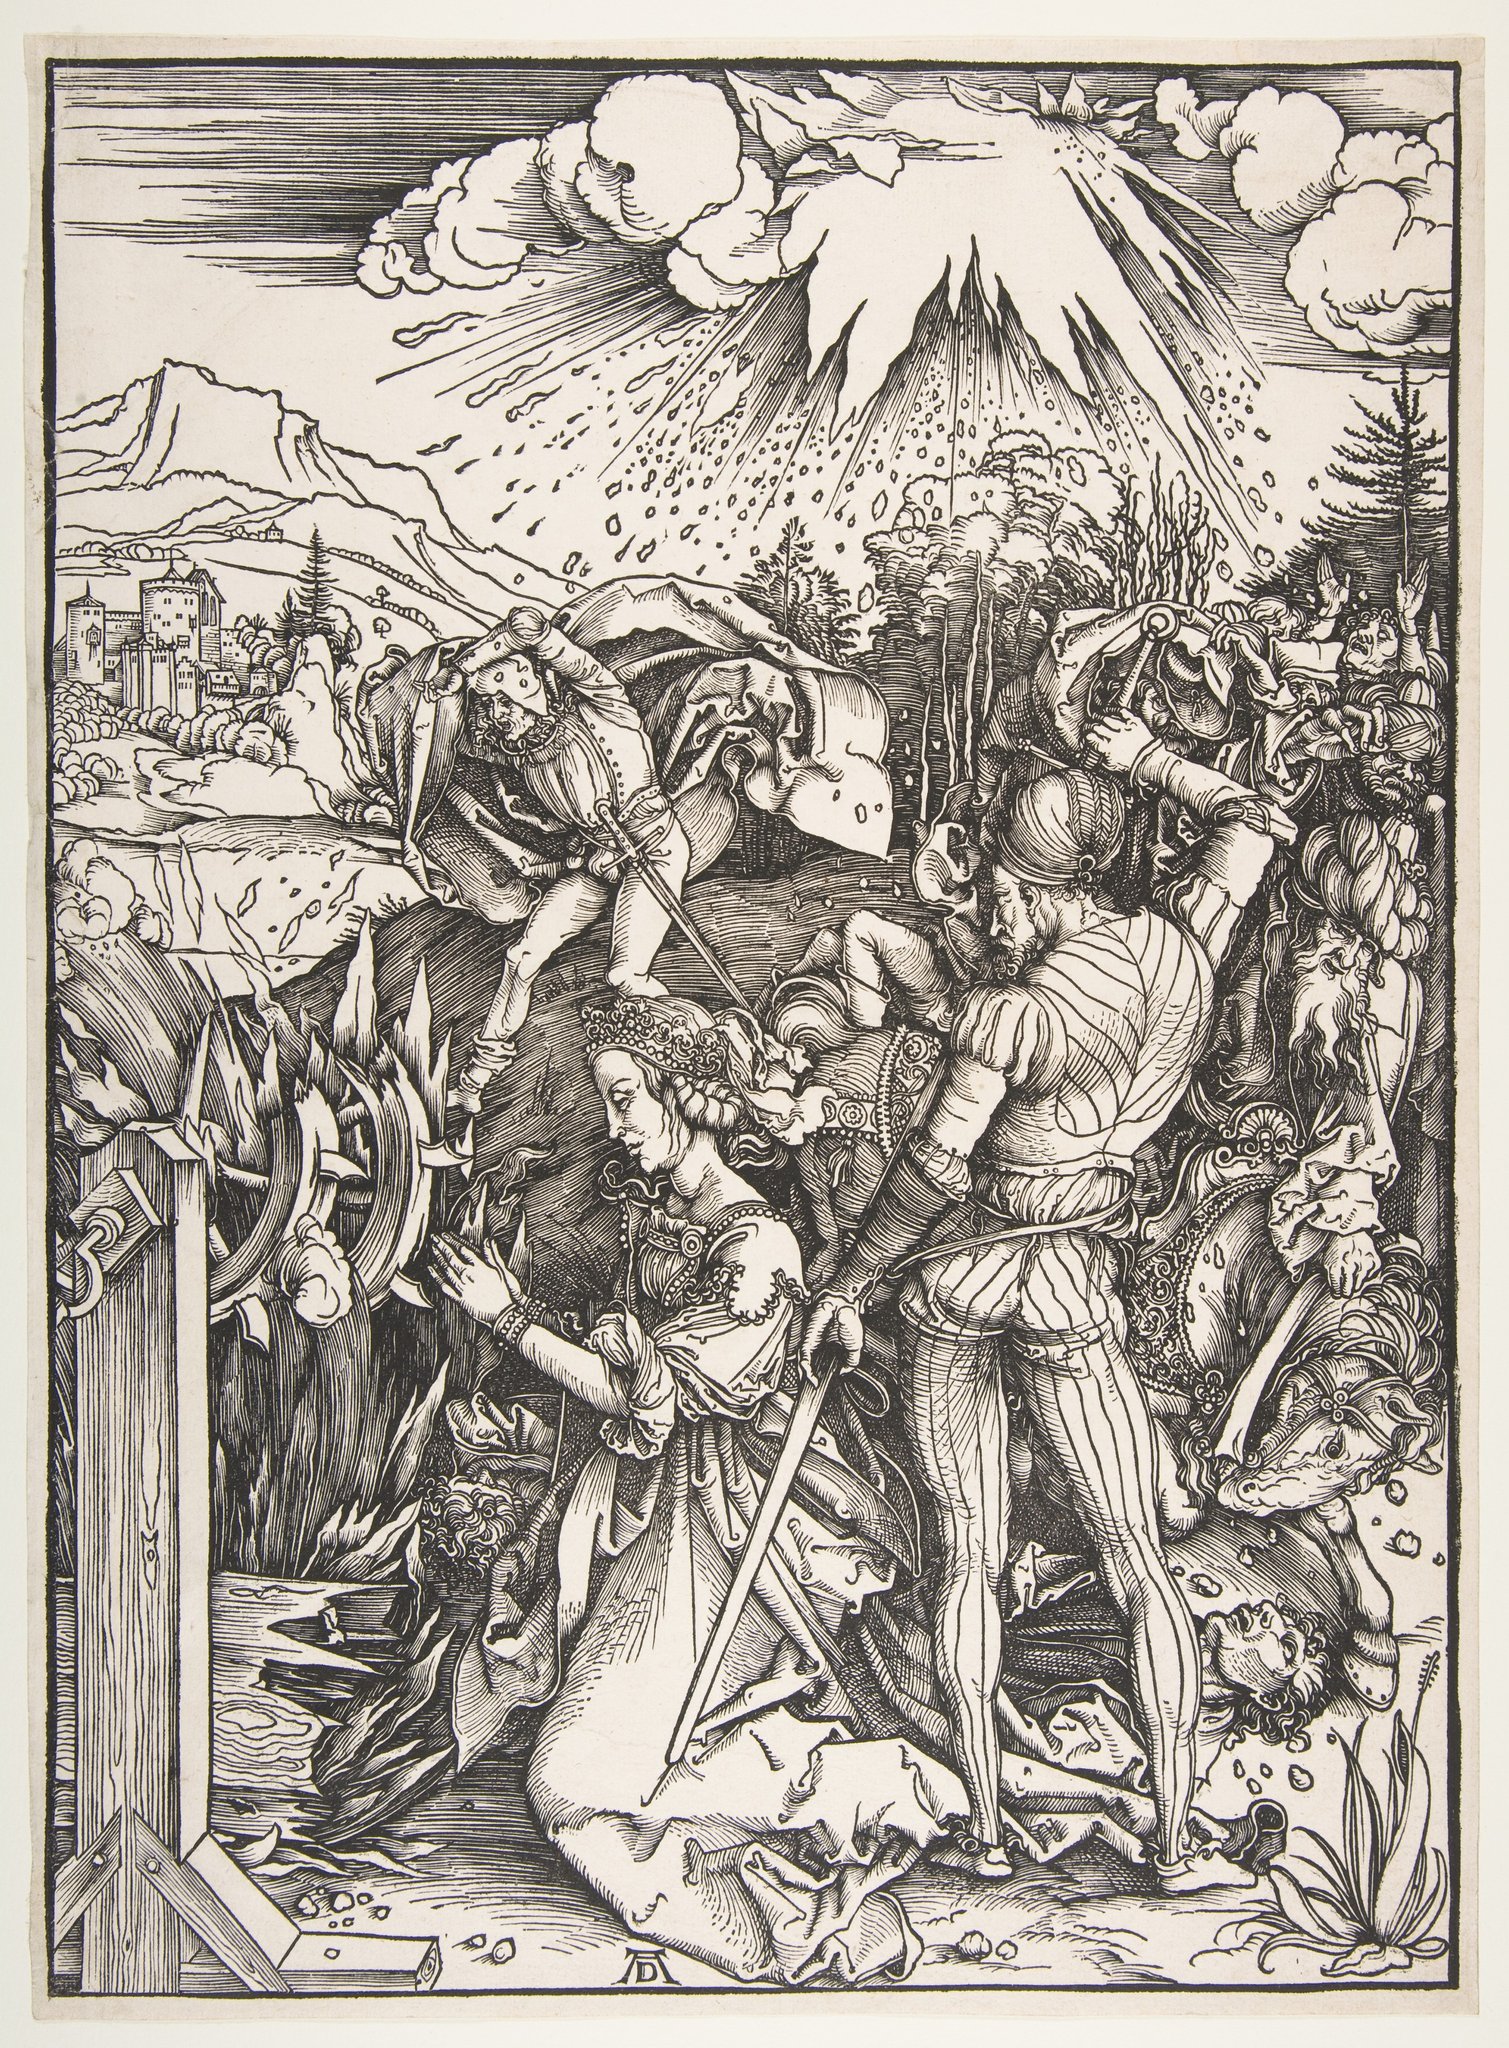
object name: print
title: The Martyrdom of Saint Catherine of Alexandria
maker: albrecht dürer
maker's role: artist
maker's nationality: german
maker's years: 1471-1528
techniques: woodcut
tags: saint catherine,punishment